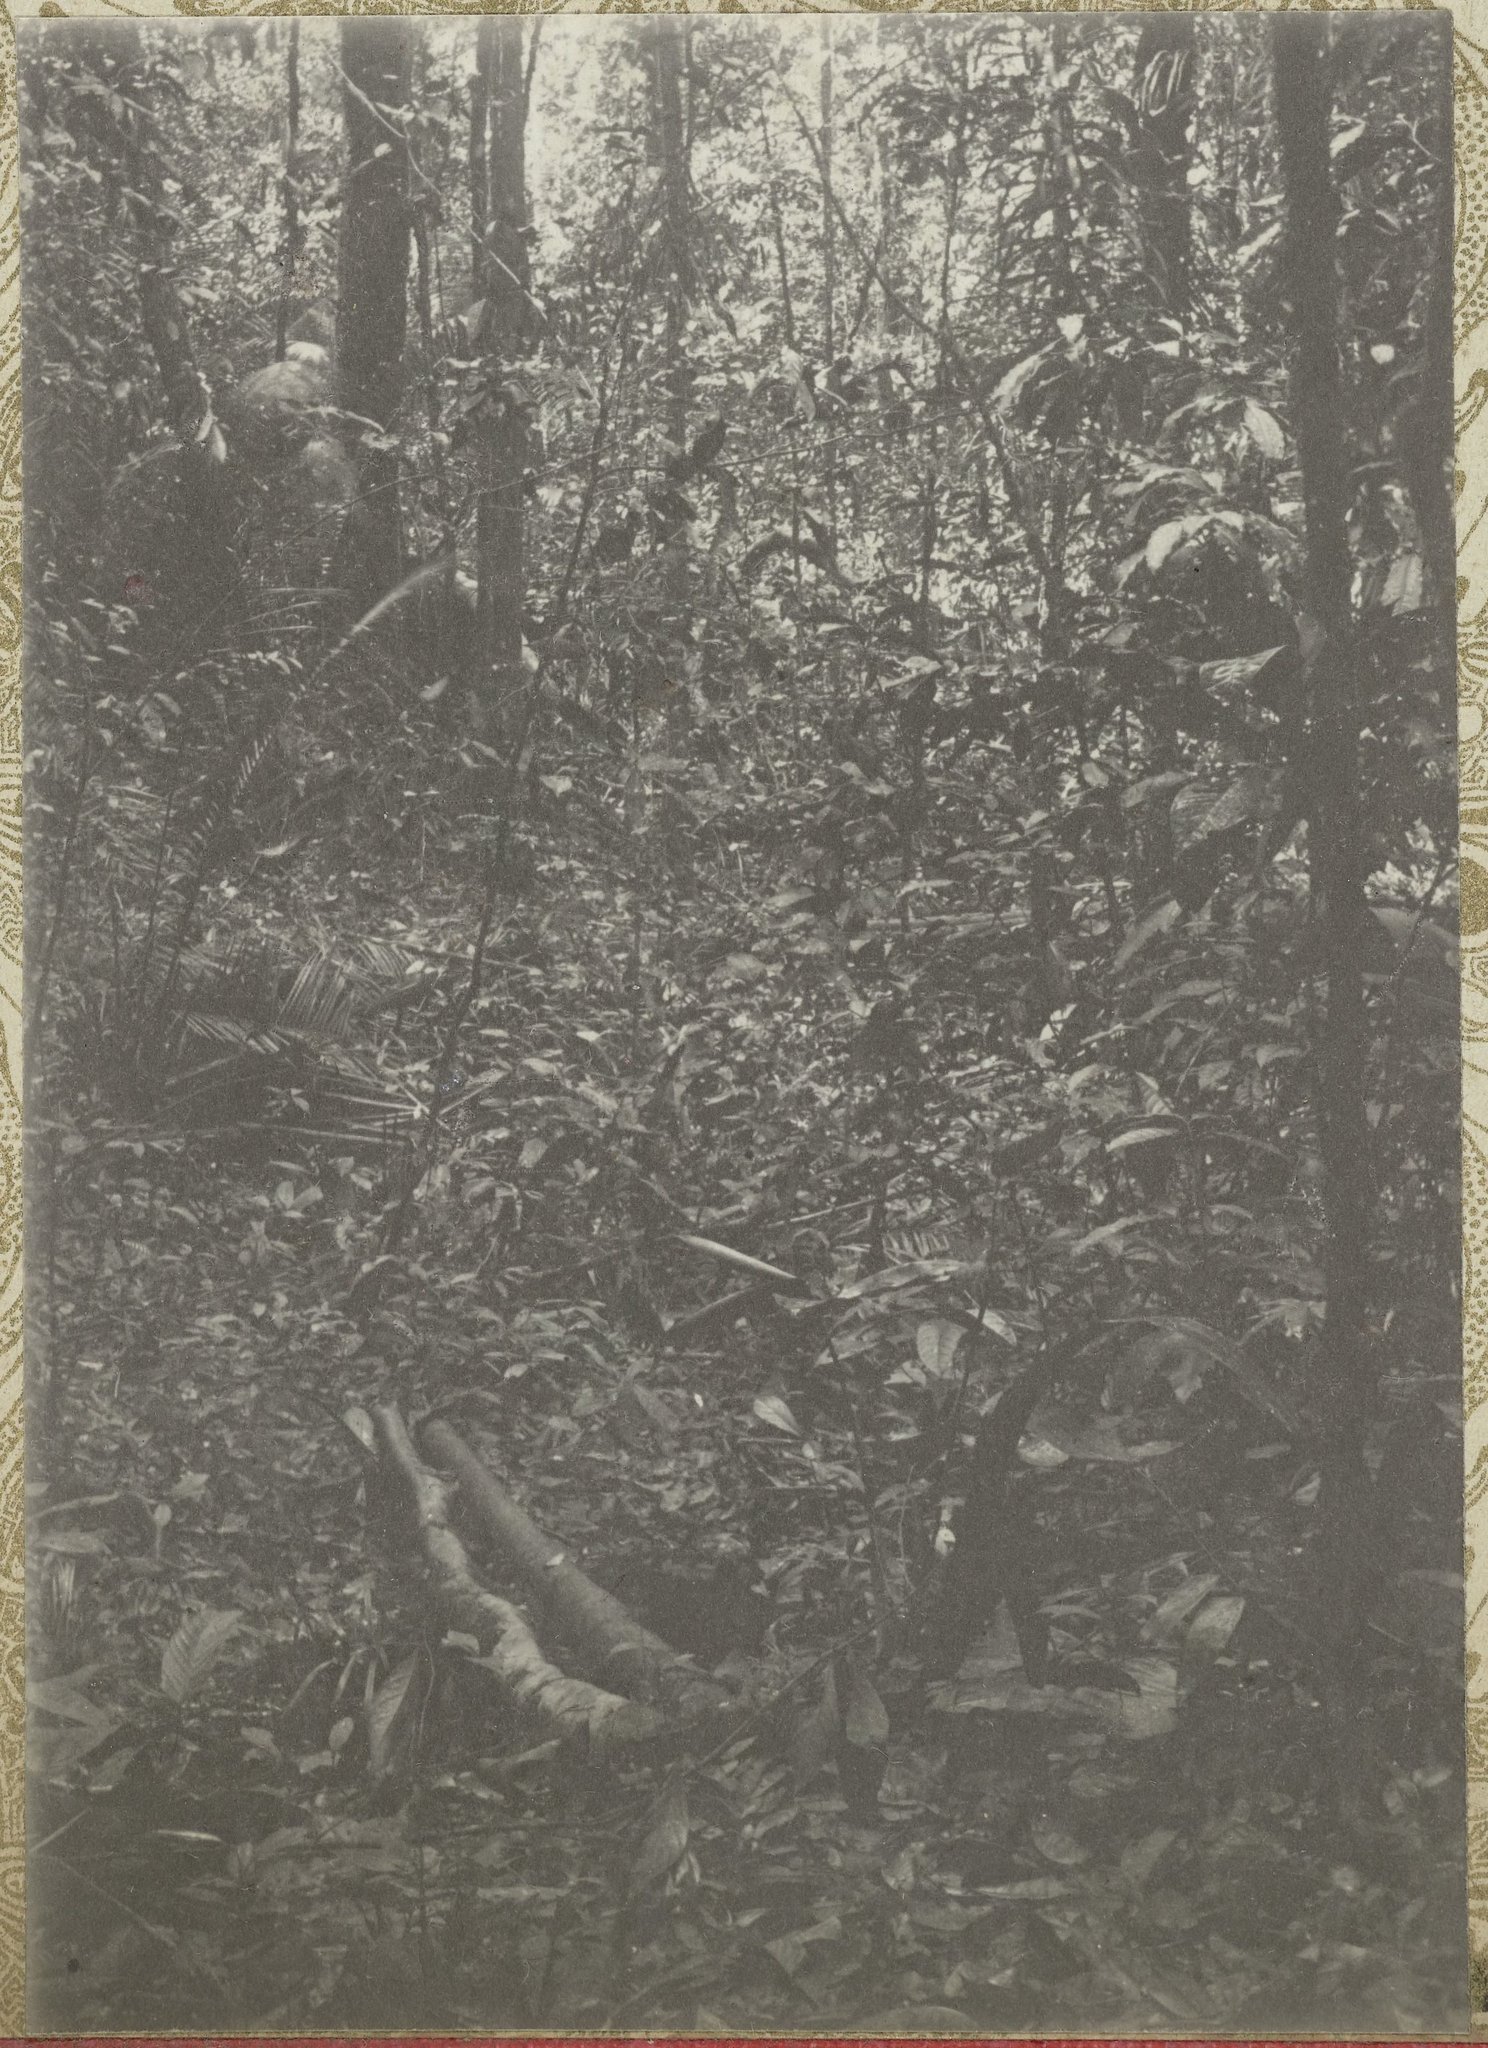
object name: photograph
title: Oerwoud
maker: hendrik doijer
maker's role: engineer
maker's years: 1863-1925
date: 1903-1910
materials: photographic support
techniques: gelatin silver print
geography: suriname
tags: suriname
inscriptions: inscription: ‘12’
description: Gezicht in het oerwoud. Onderdeel van het fotoalbum Souvenir de Voyage (deel 1), over het leven van de familie Doijer in en rond de plantage Ma Retraite in Suriname in de jaren 1903-1910.